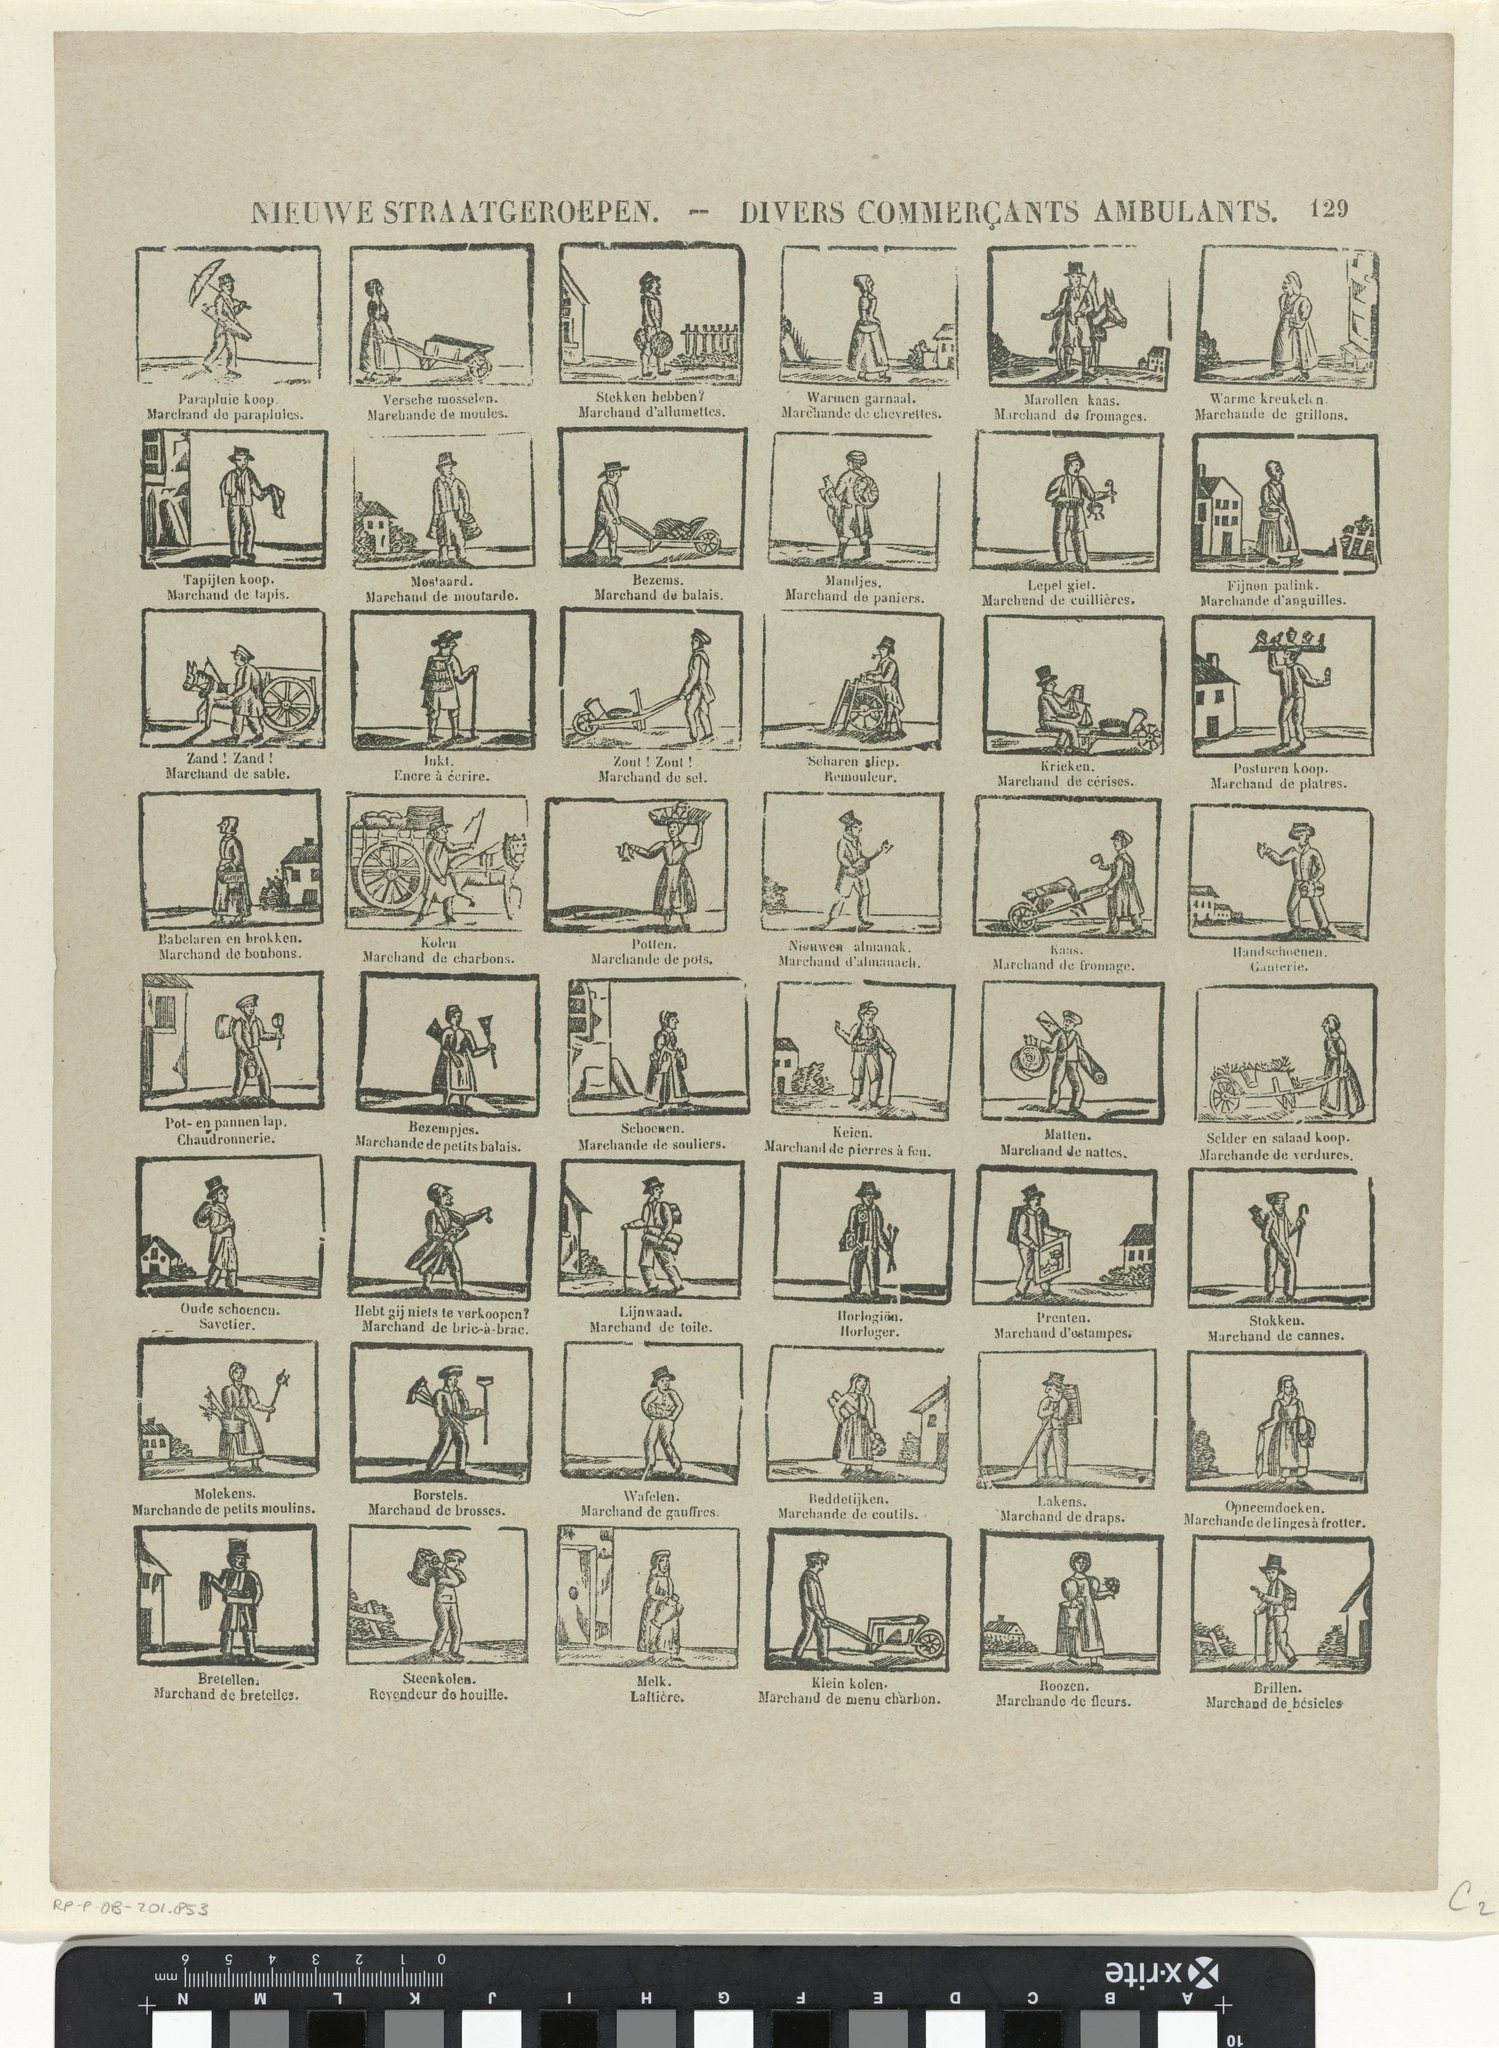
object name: print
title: Nieuwe straatgeroepen / Divers commerçants ambulants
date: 1800-1833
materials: paper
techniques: letterpress printing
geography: turnhout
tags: street-trader, merchant, salesman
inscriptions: collector's mark: Lugt 2760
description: Blad met 48 voorstellingen van straatverkopers. Onder elke afbeelding een onderschrift in het Nederlands en in het Frans. Genummerd rechtsboven: 129.